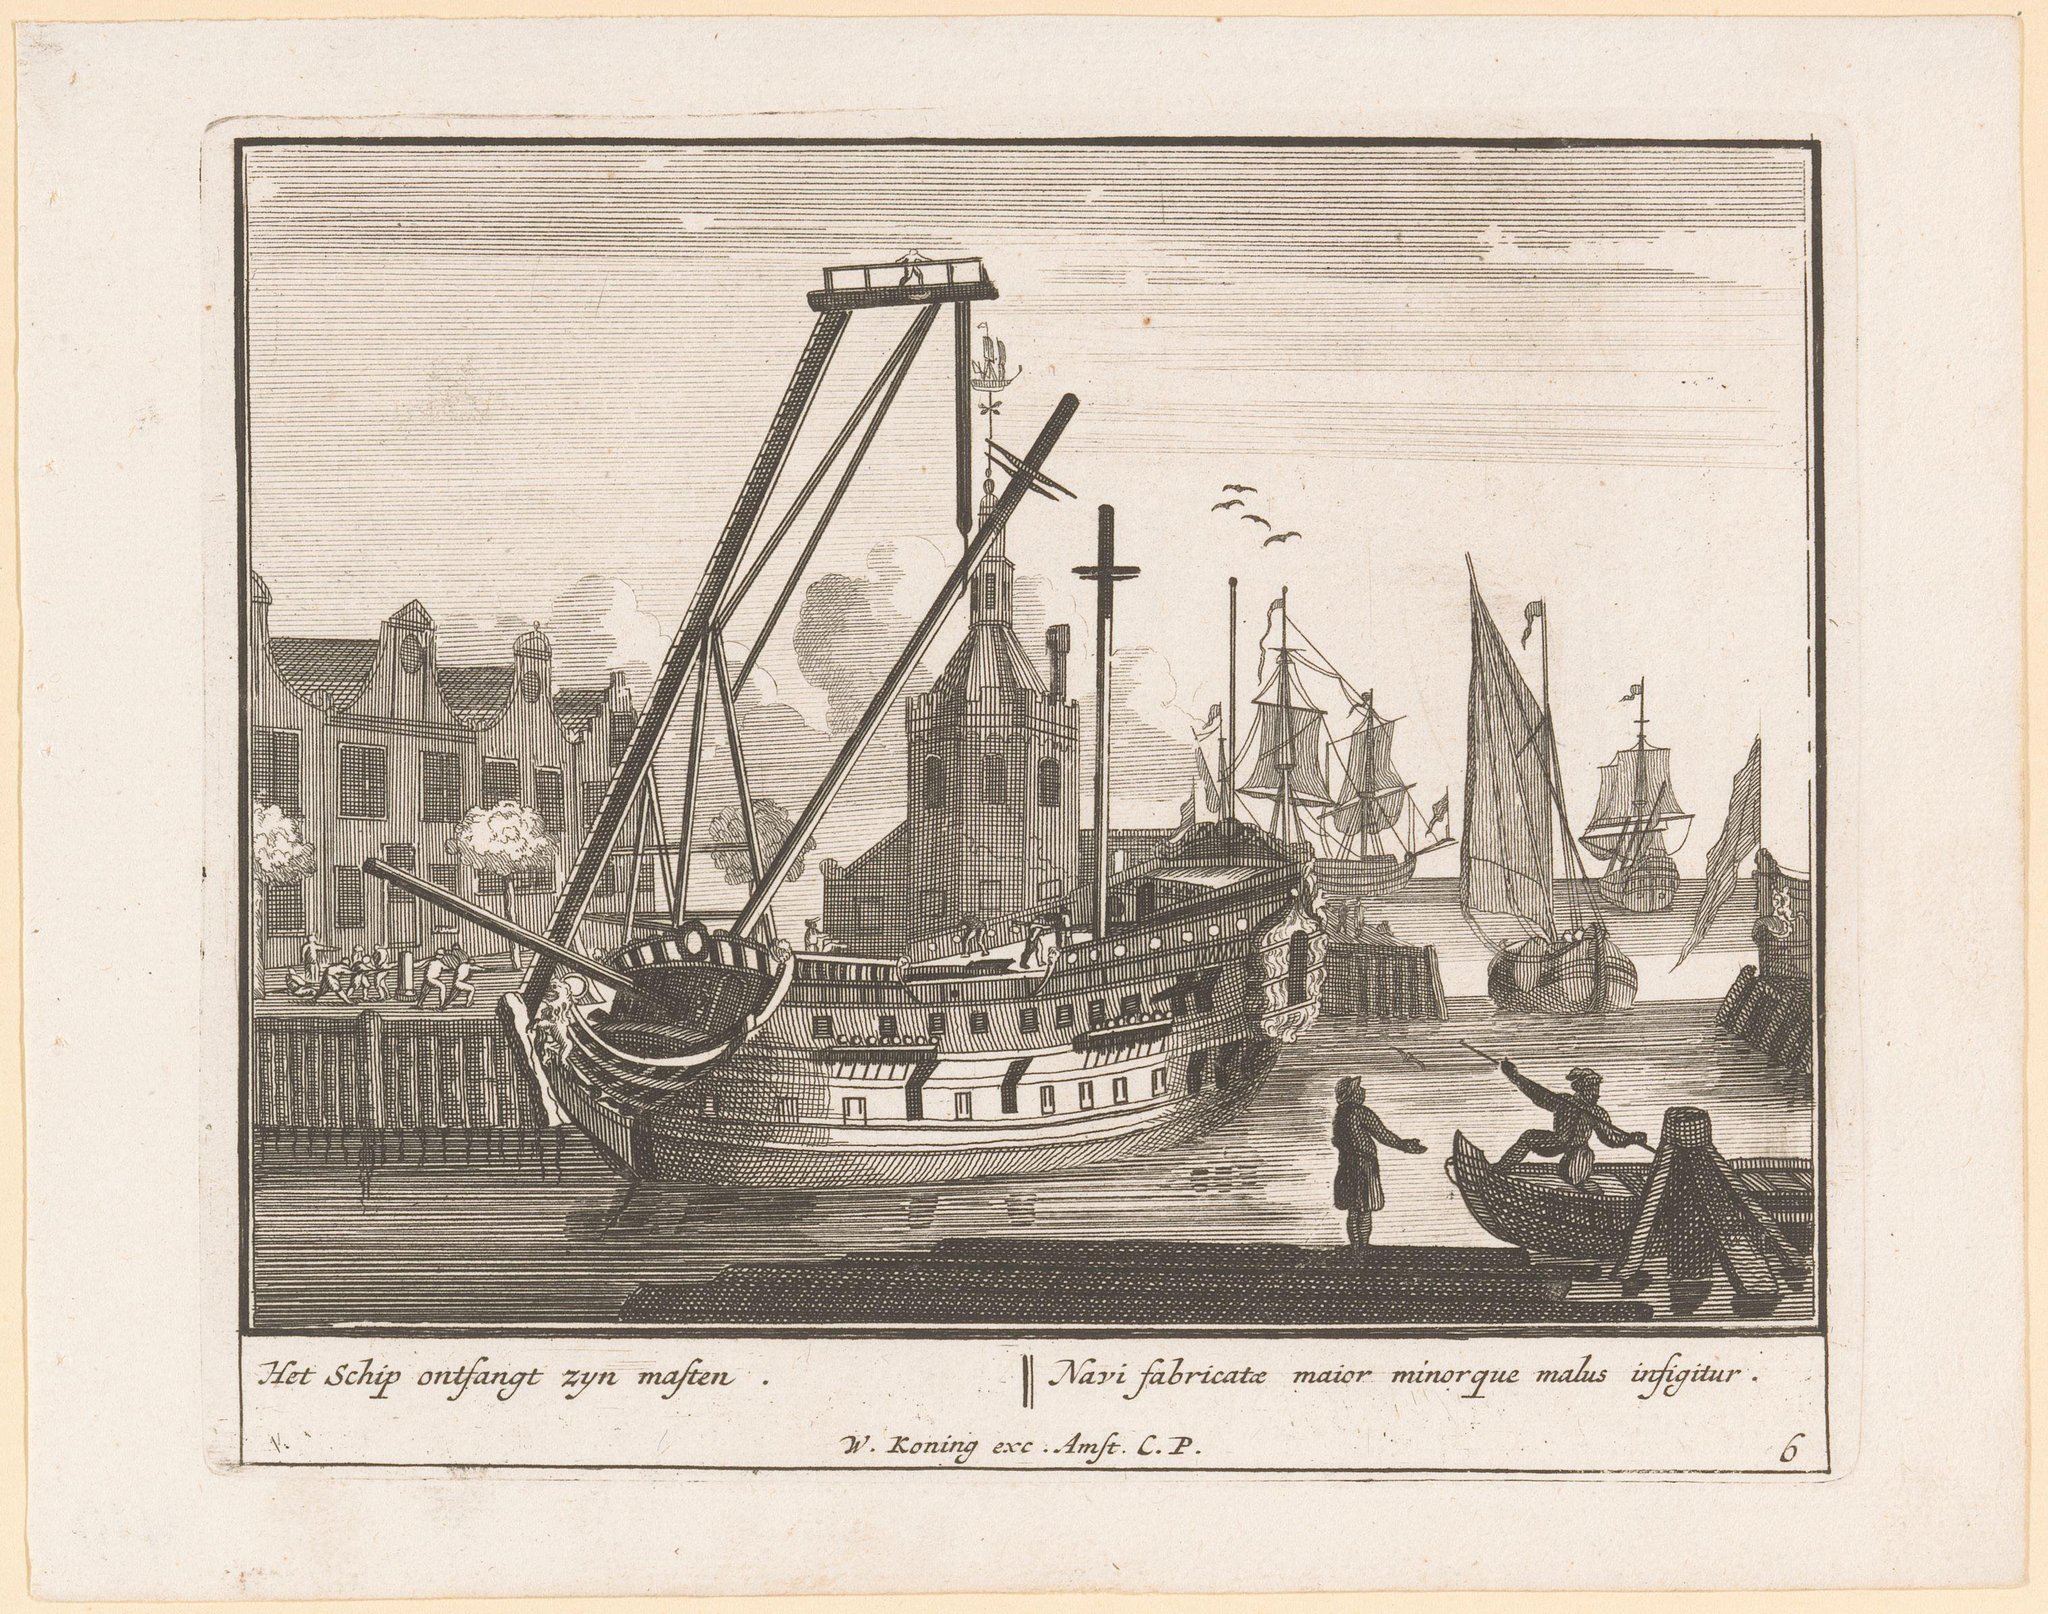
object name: print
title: Navigiorum Aedificatio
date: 1717-1732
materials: paper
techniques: engraving, etching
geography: northern netherlands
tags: building a ship, ship under construction, shipyard, shipdock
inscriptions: watermark, collector's mark: Lugt 2228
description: Maakt deel uit van een zestiendelige serie met verschillende schepen in aanbouw en enkele ongelukken, getiteld 'Navigiorum Aedificatio' naar prenten door Siewert van der Meulen, uitgegeven door Isaac Greve en Wilhelmus Koning.